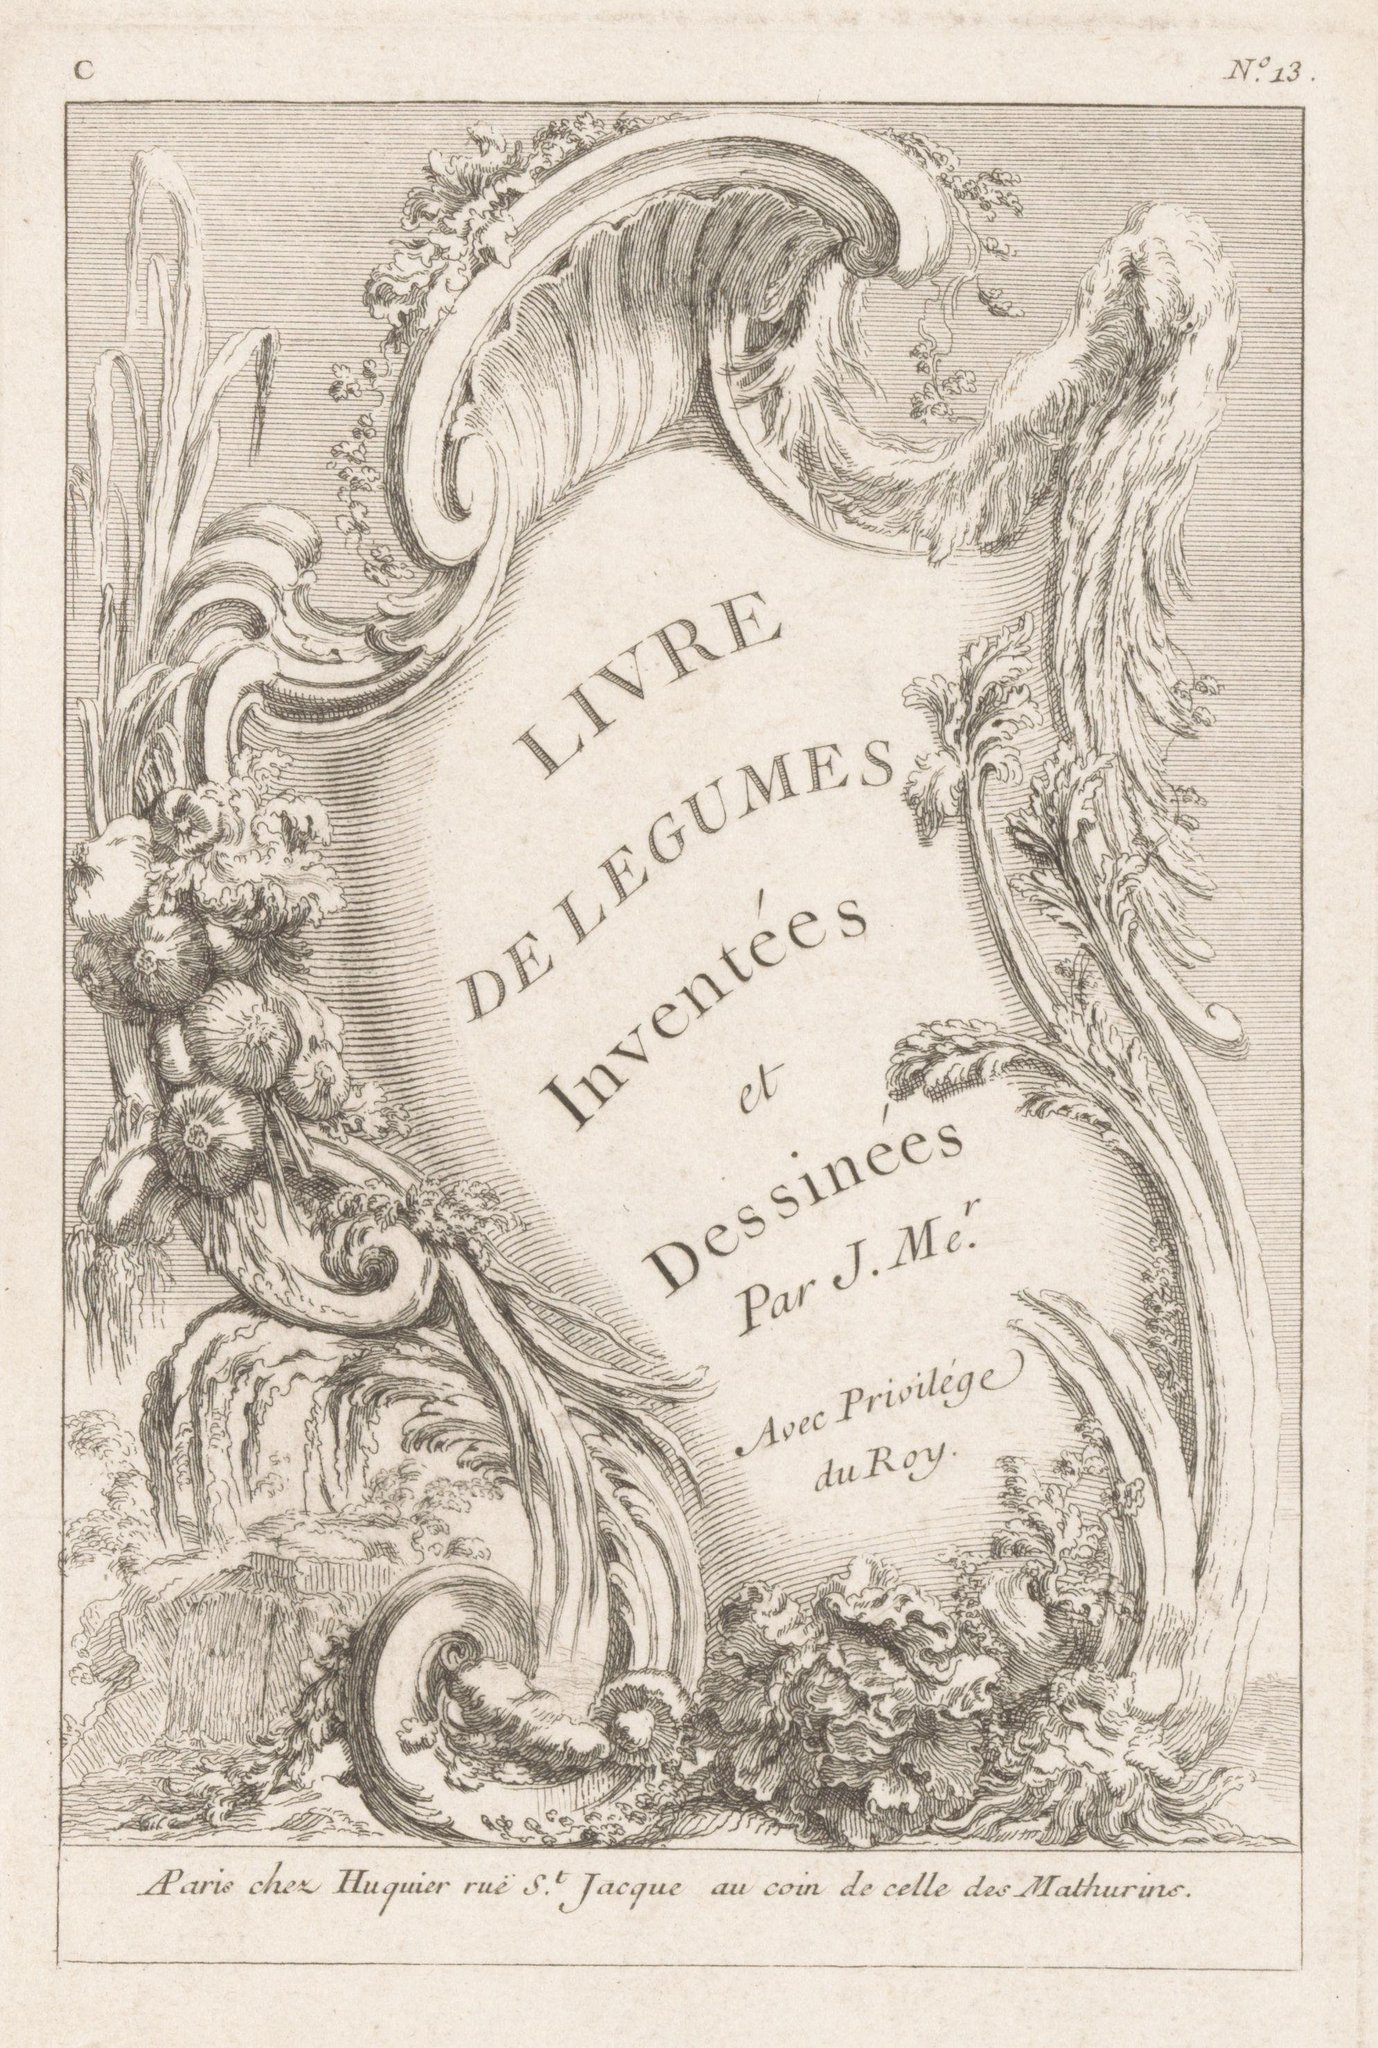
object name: print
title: Oeuvre de Juste Aurele Meissonnier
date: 1738-1749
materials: paper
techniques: etching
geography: paris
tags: vegetables, ornament ~ cartouche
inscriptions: collector's mark: Lugt 2228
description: Een rocaille cartouche met de serietitel omgeven door bladeren en groente. Prentnummer 13.